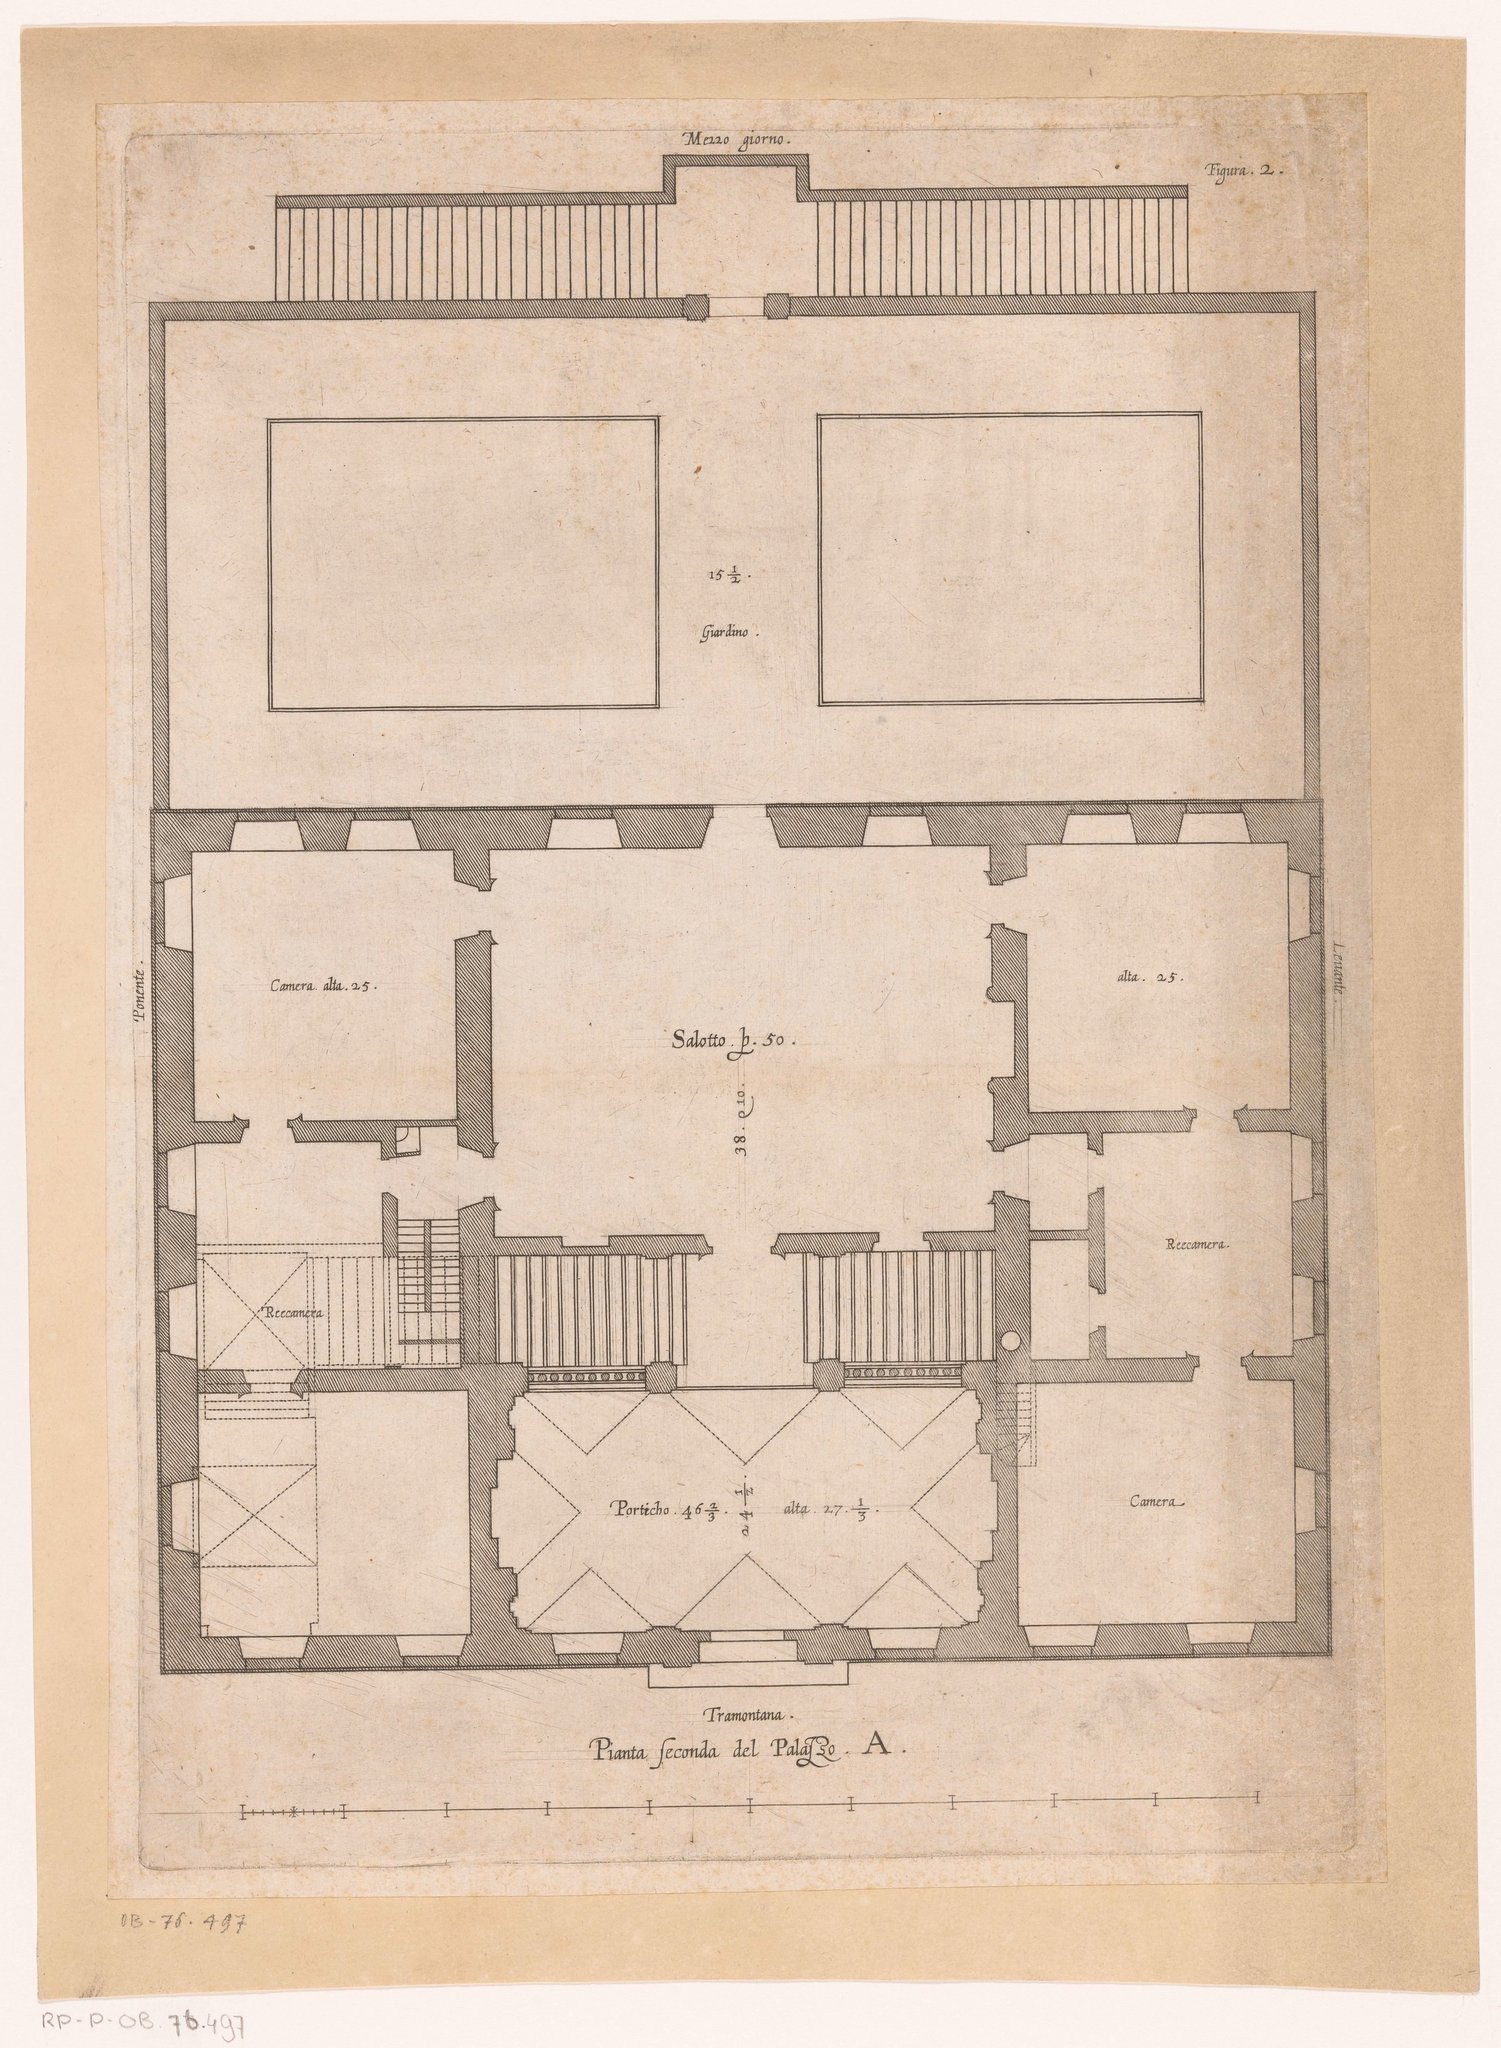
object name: print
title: Pianta seconda del Palazzo. A.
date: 1622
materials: paper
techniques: engraving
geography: antwerp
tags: hôtel, i.e. small palace in city - aa - civic architecture: inside, plan ~ architecture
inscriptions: collector's mark: Lugt 240